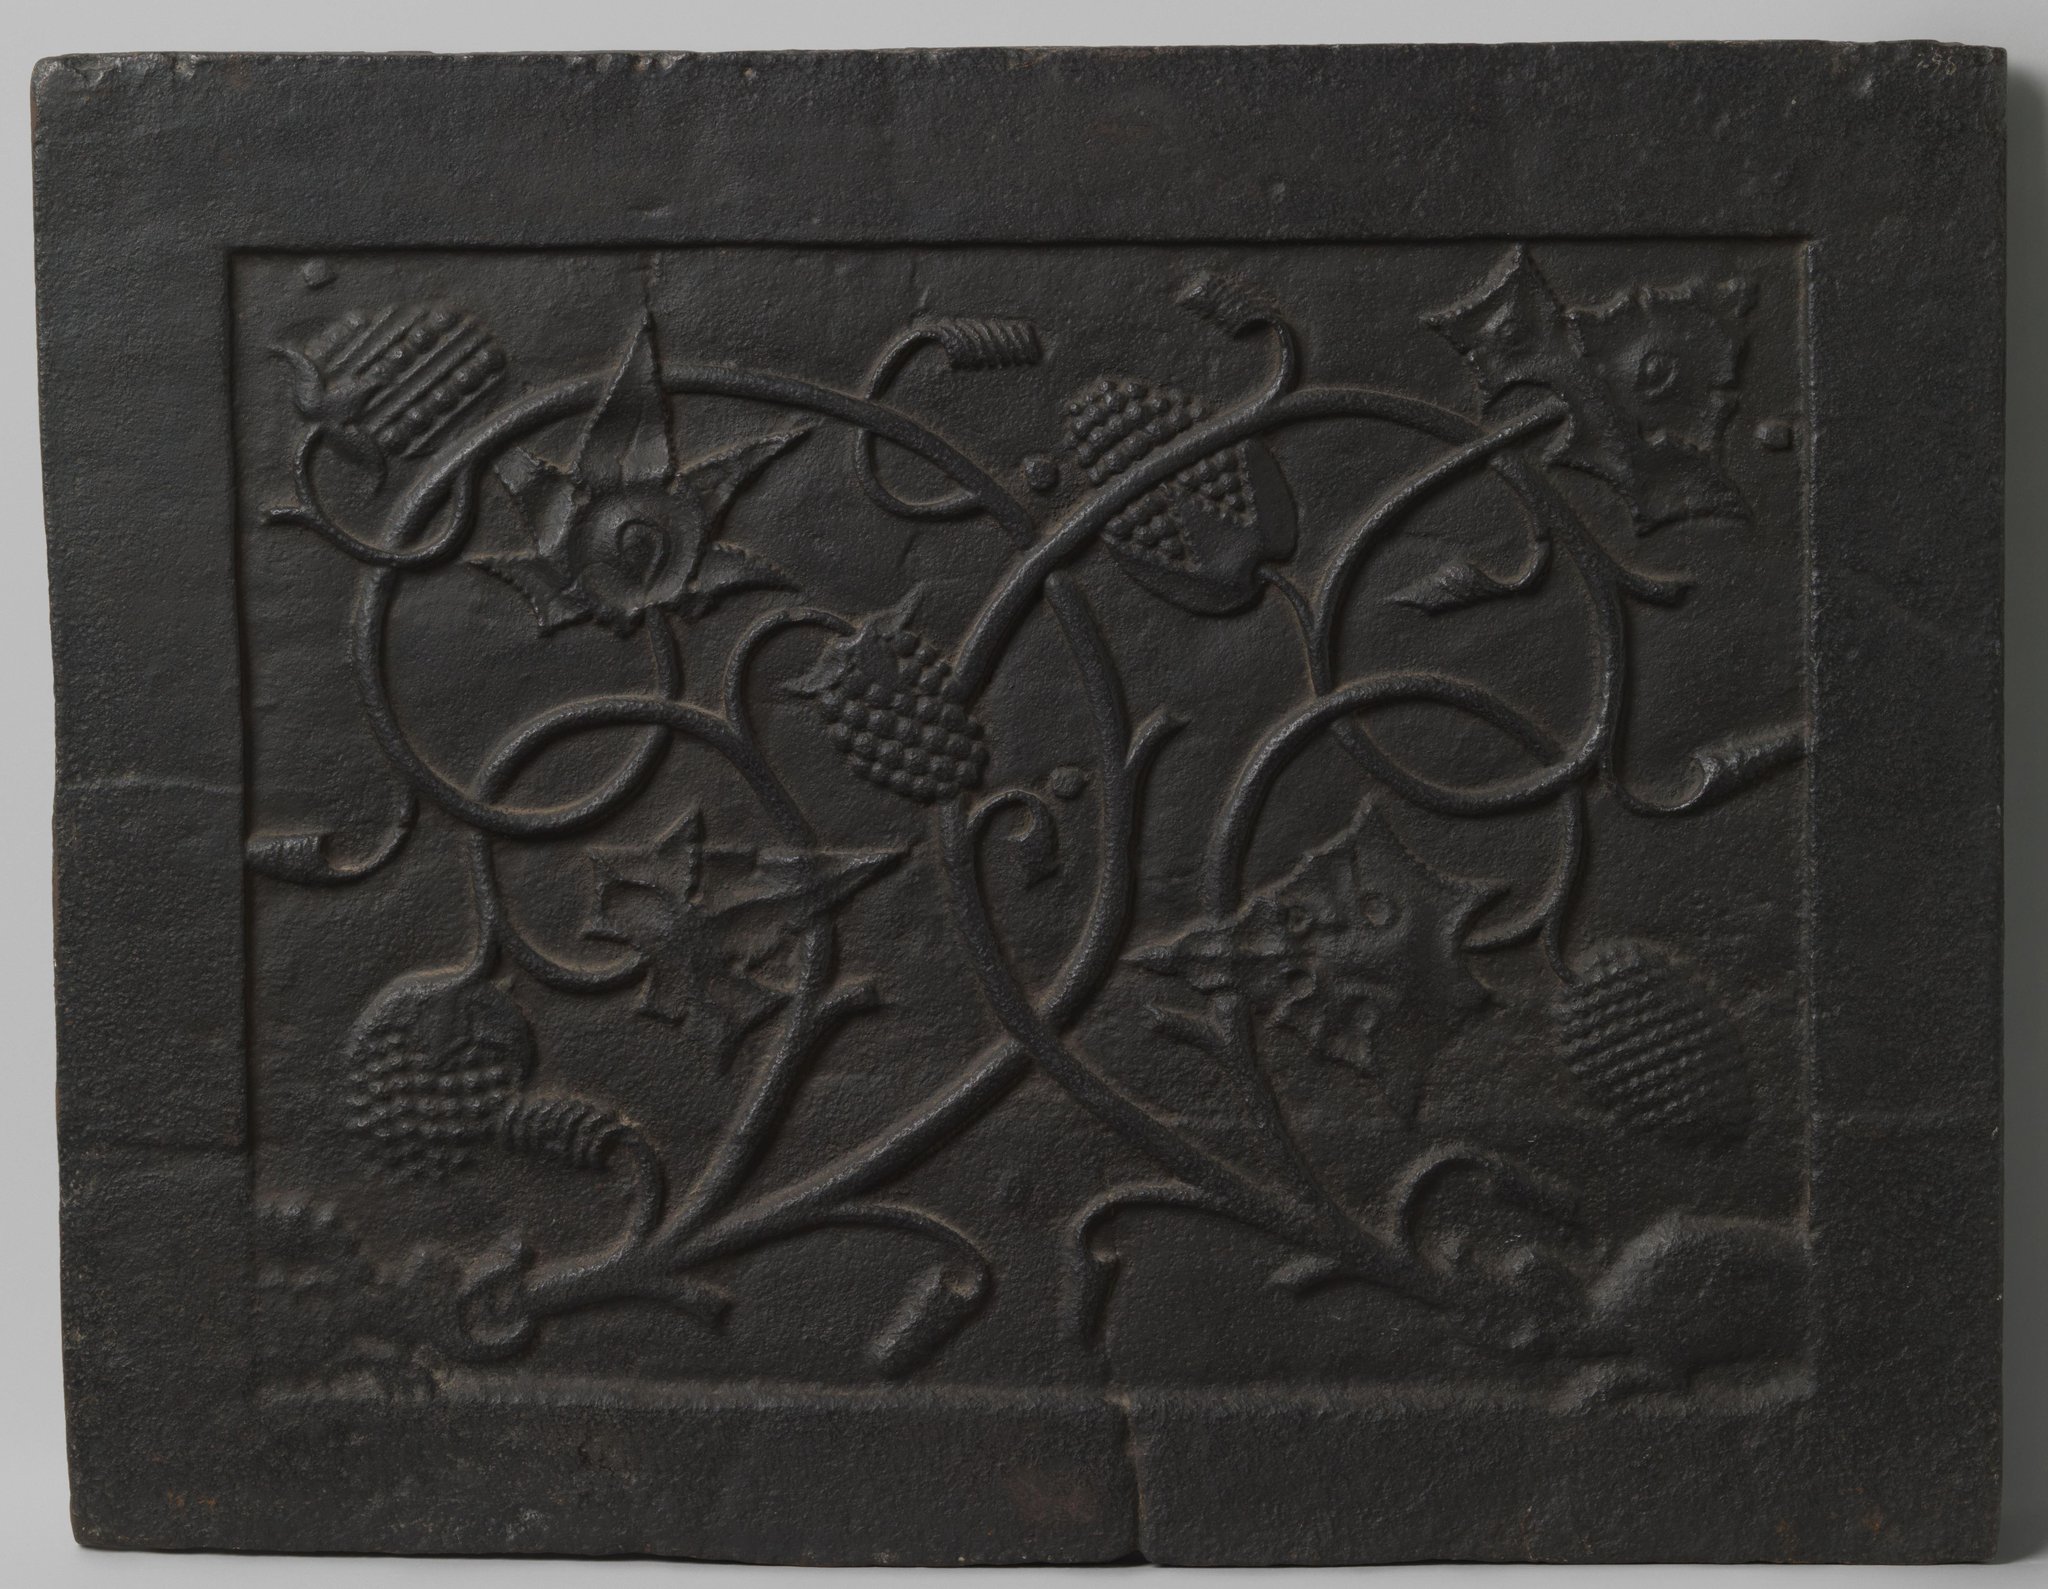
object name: fireback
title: Haardplaat met wijnranken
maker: Anonymous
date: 1500-1600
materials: iron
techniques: casting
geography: germany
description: Haardplaat van gietijzer, versierd met twee min of meer symmetrische wijnranken met bladeren en druiventrossen. Het geheel wordt omlijst met een brede, onversierde rand.